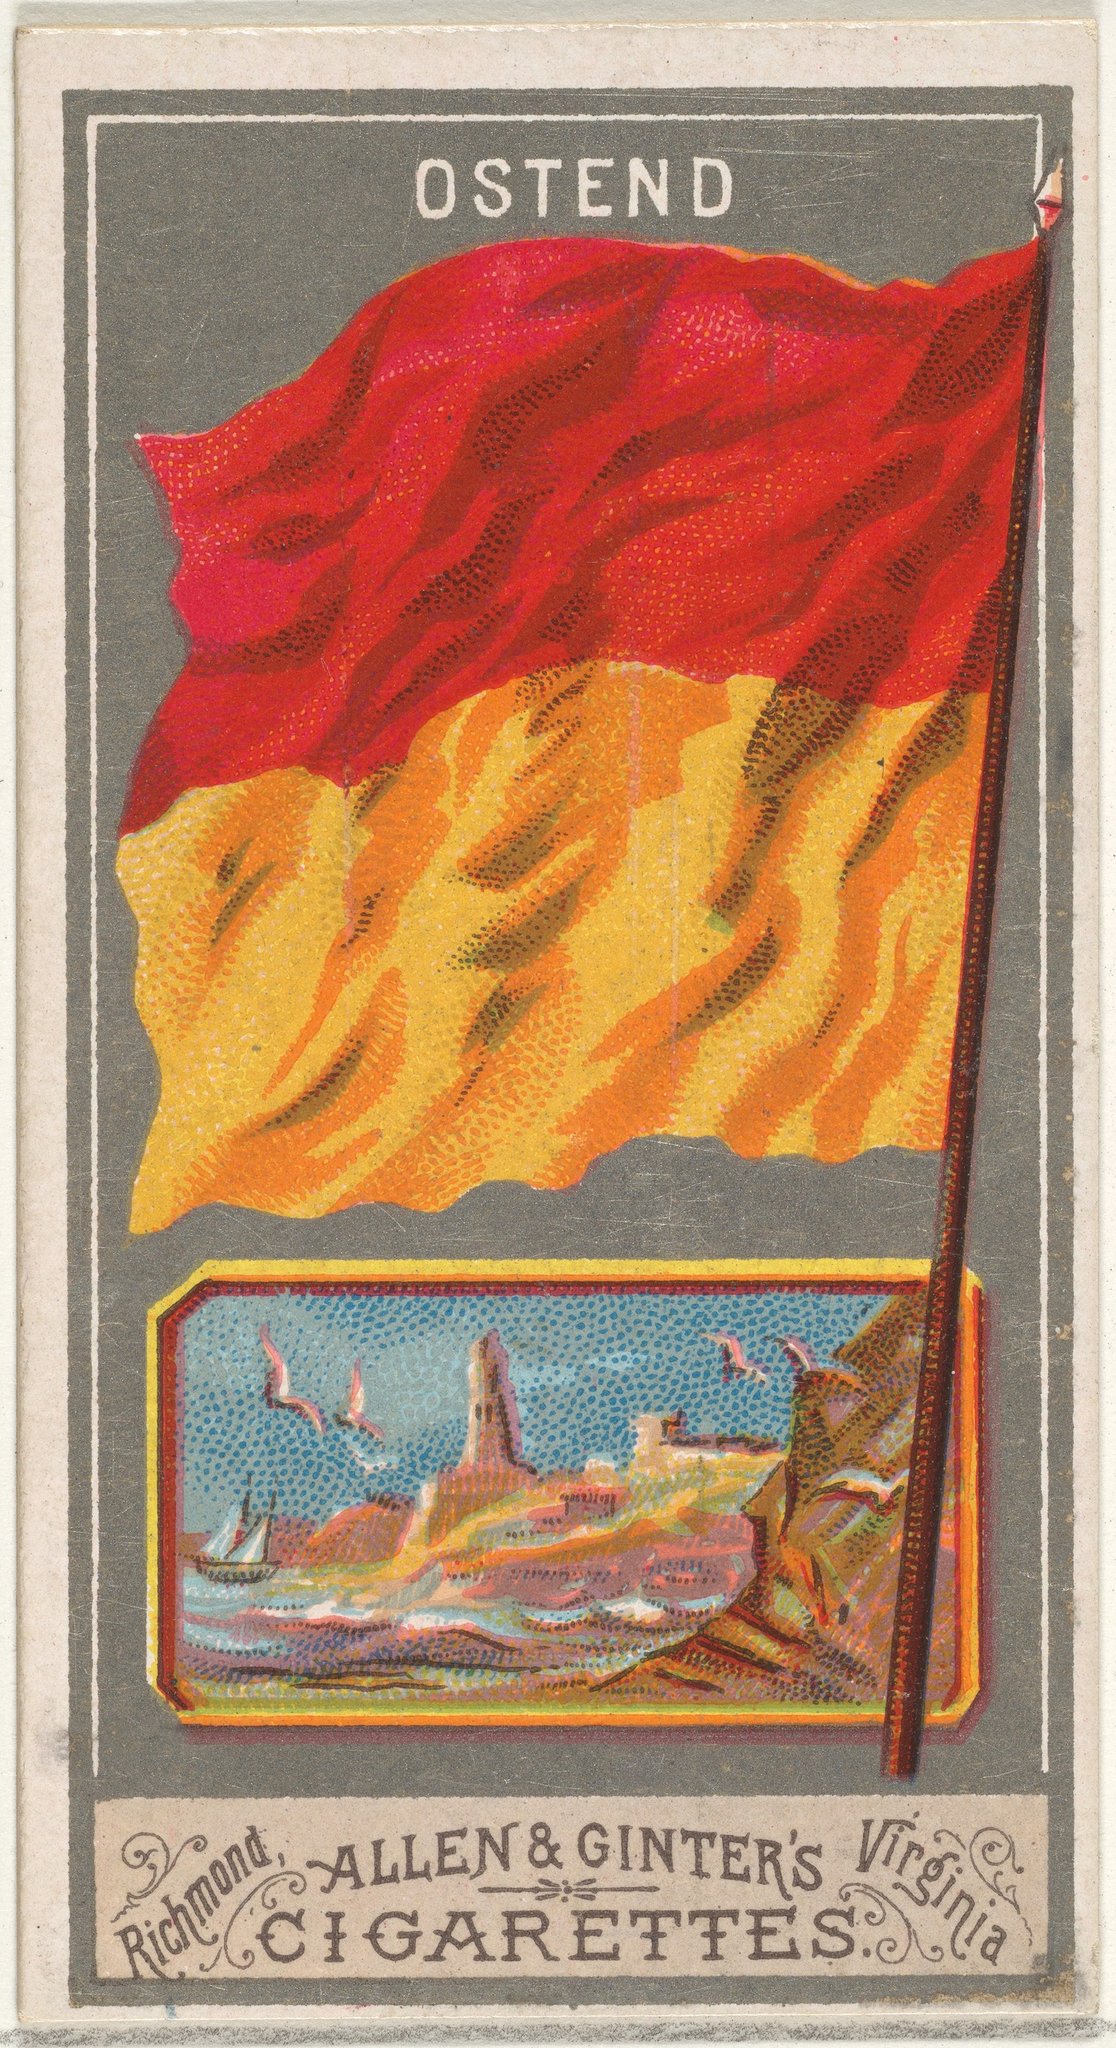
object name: print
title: Ostend, from the City Flags series (N6) for Allen & Ginter Cigarettes Brands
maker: allen & ginter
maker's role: publisher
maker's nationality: american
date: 1887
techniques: color lithograph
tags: flags